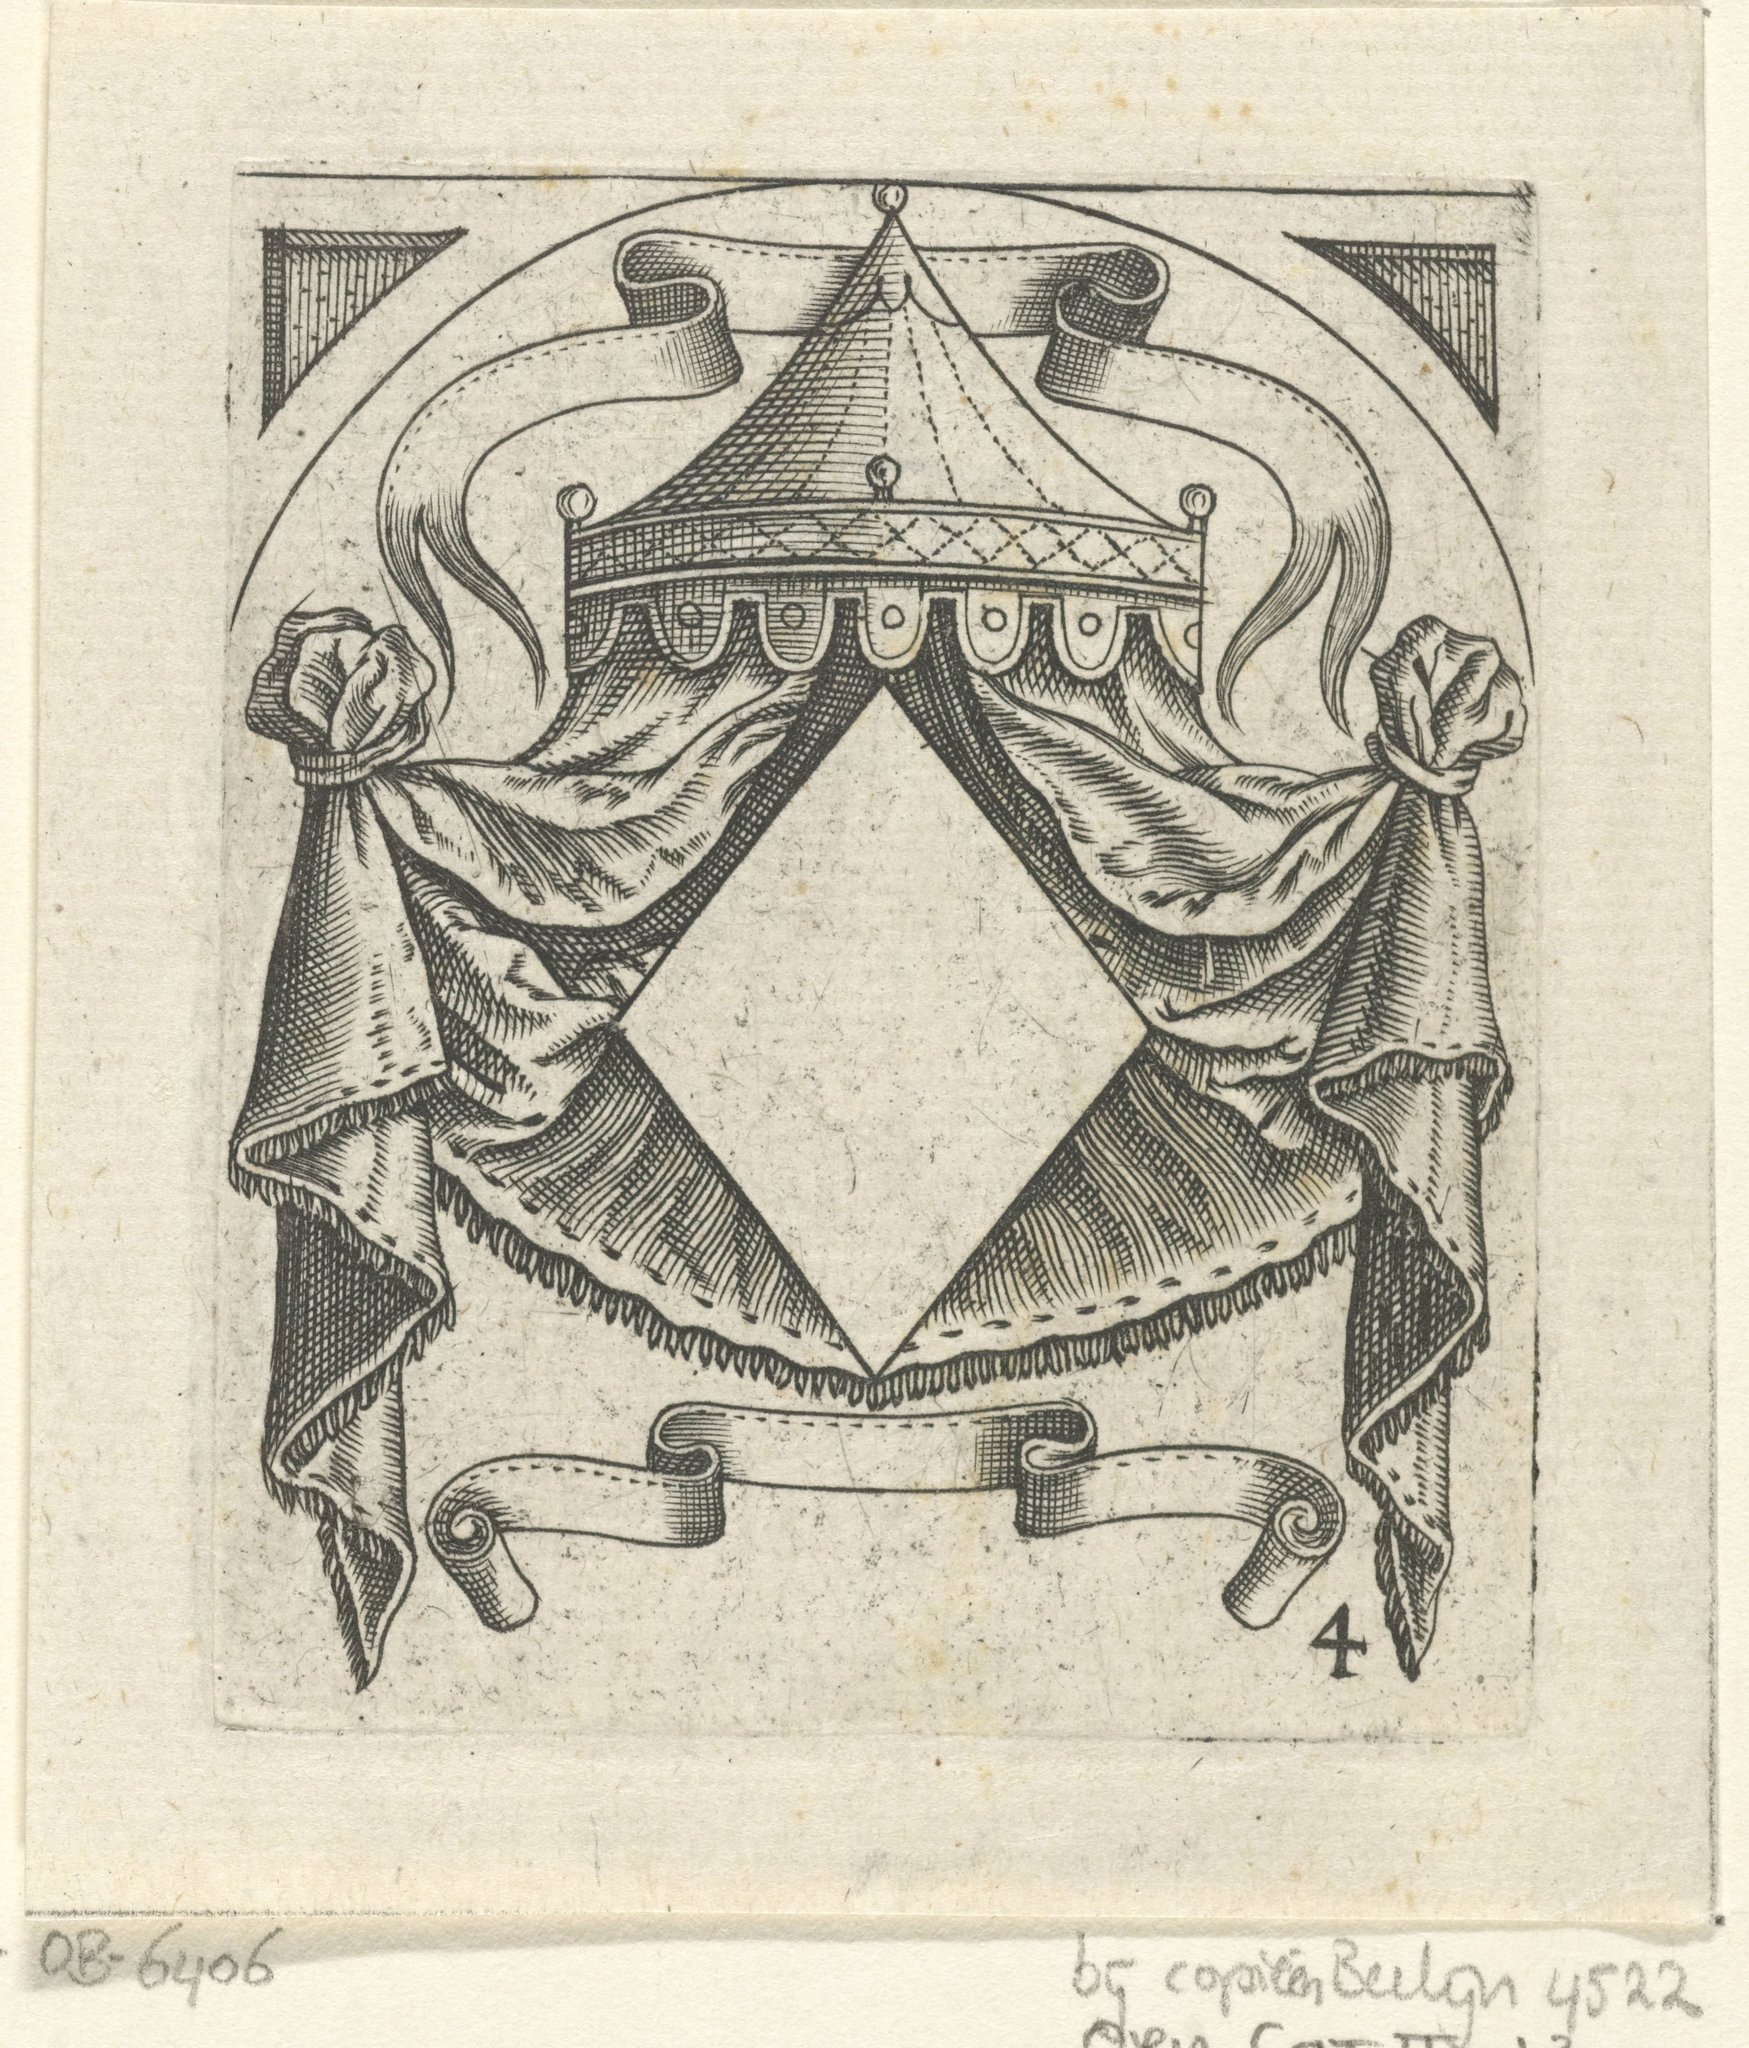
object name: print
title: Verscheyden Wapenen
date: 1625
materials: paper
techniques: engraving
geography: amsterdam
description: Blad uit serie wapenschilden met lege compartimenten.